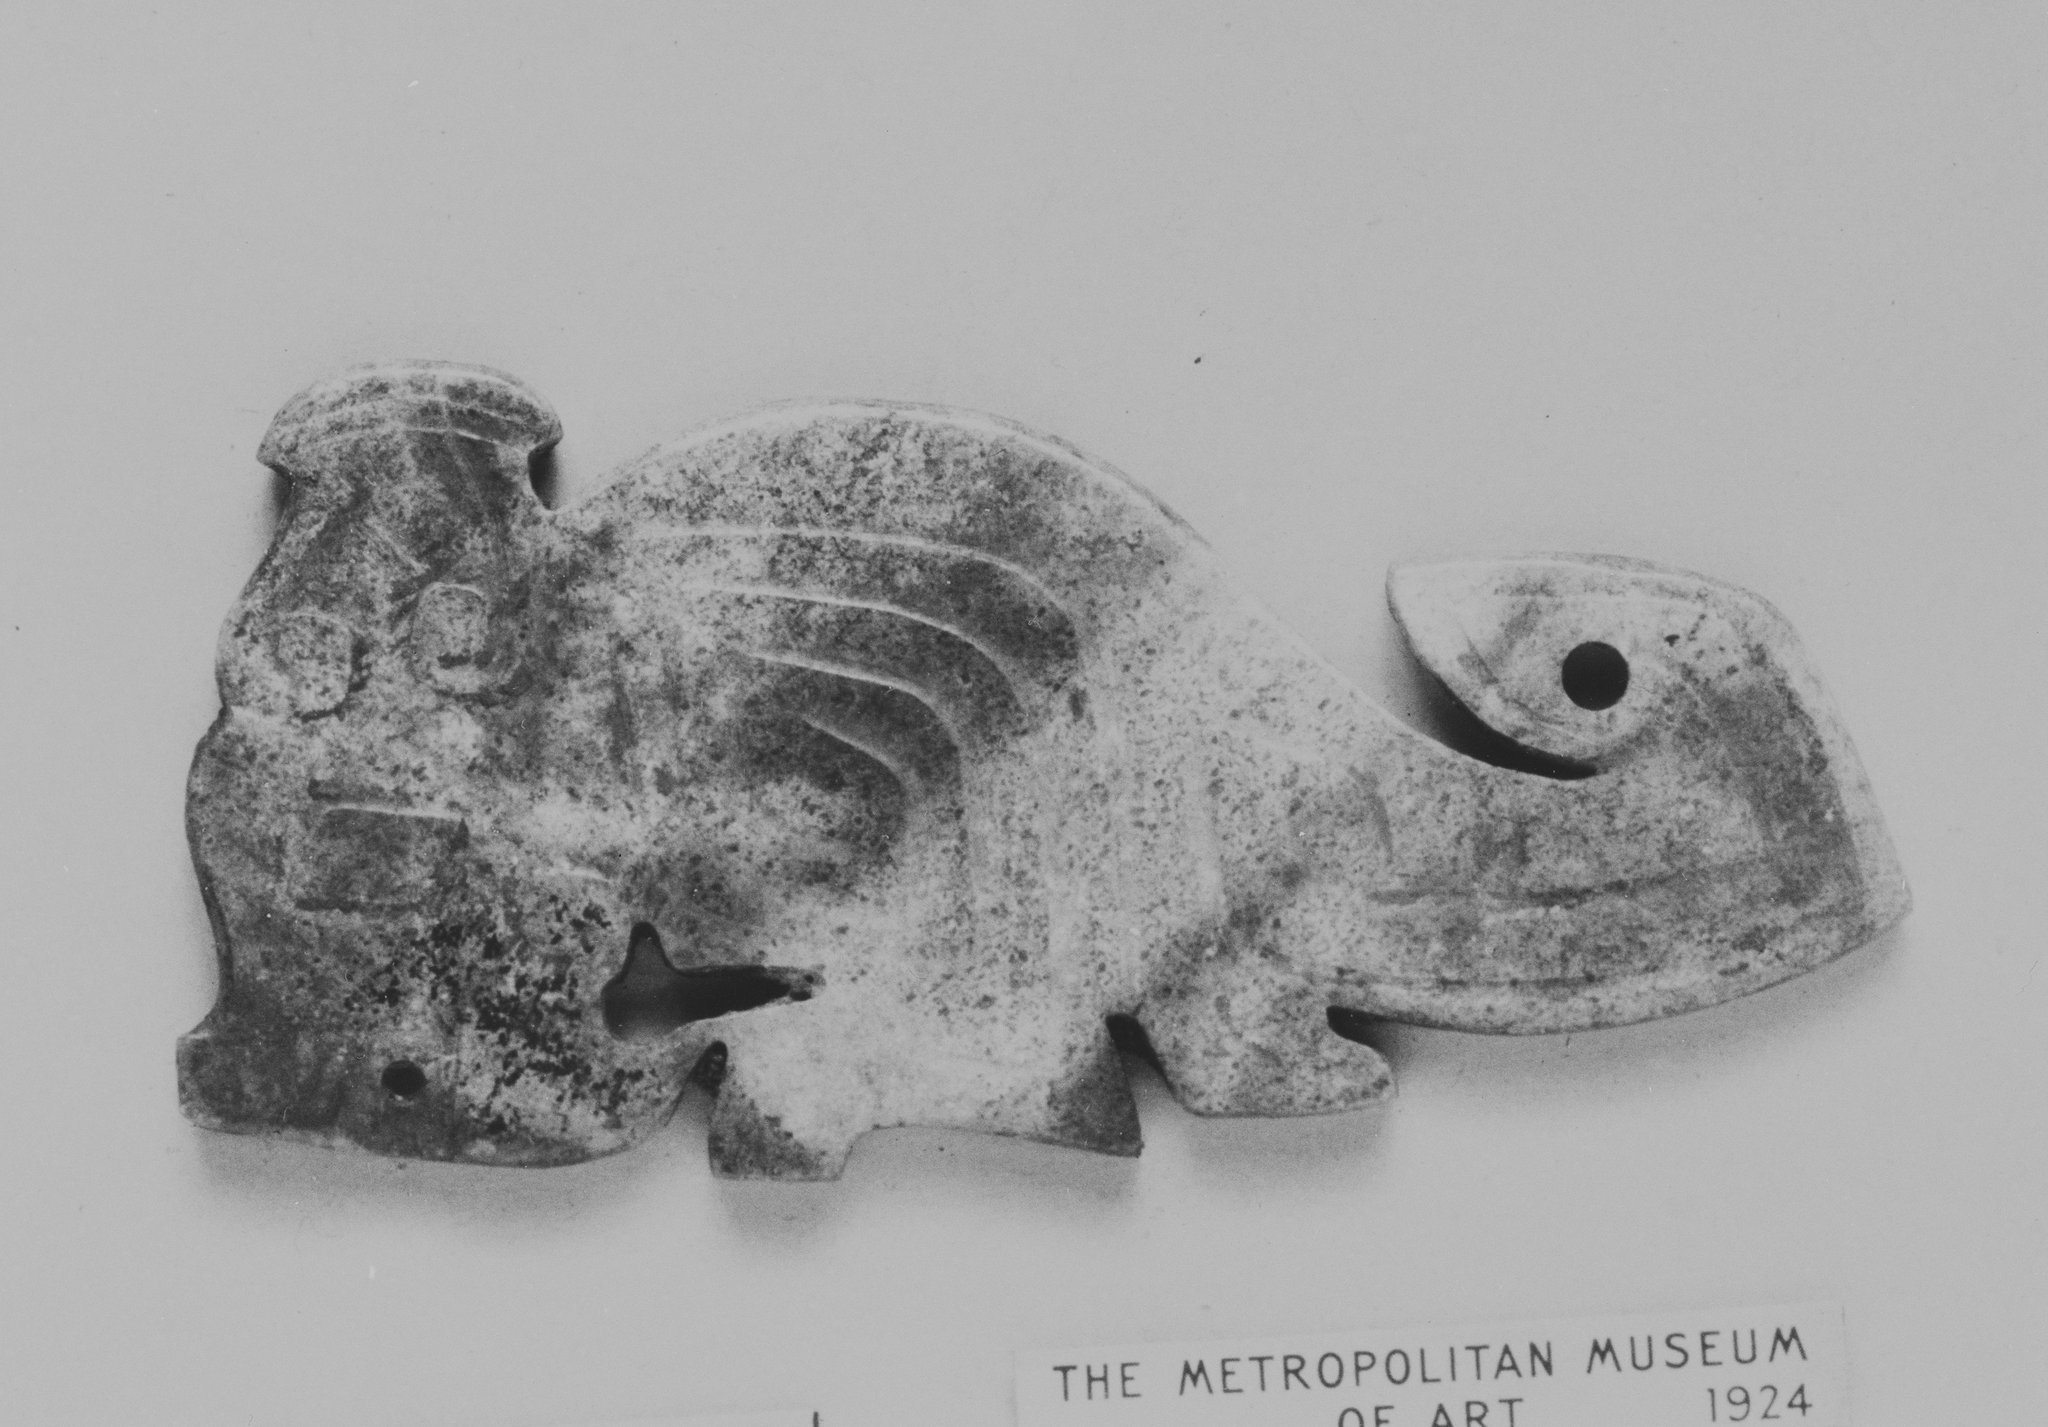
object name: pendant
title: Pendant in the shape of a dragon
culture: chinese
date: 1100-901 BCE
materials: jade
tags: dragons